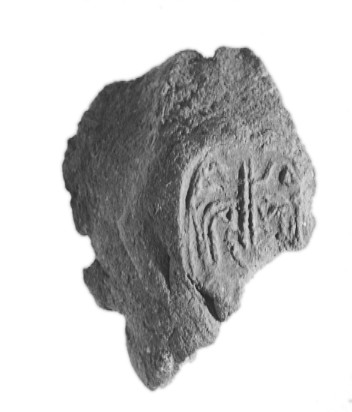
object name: sealing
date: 2030-1640 BCE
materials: clay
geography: egypt